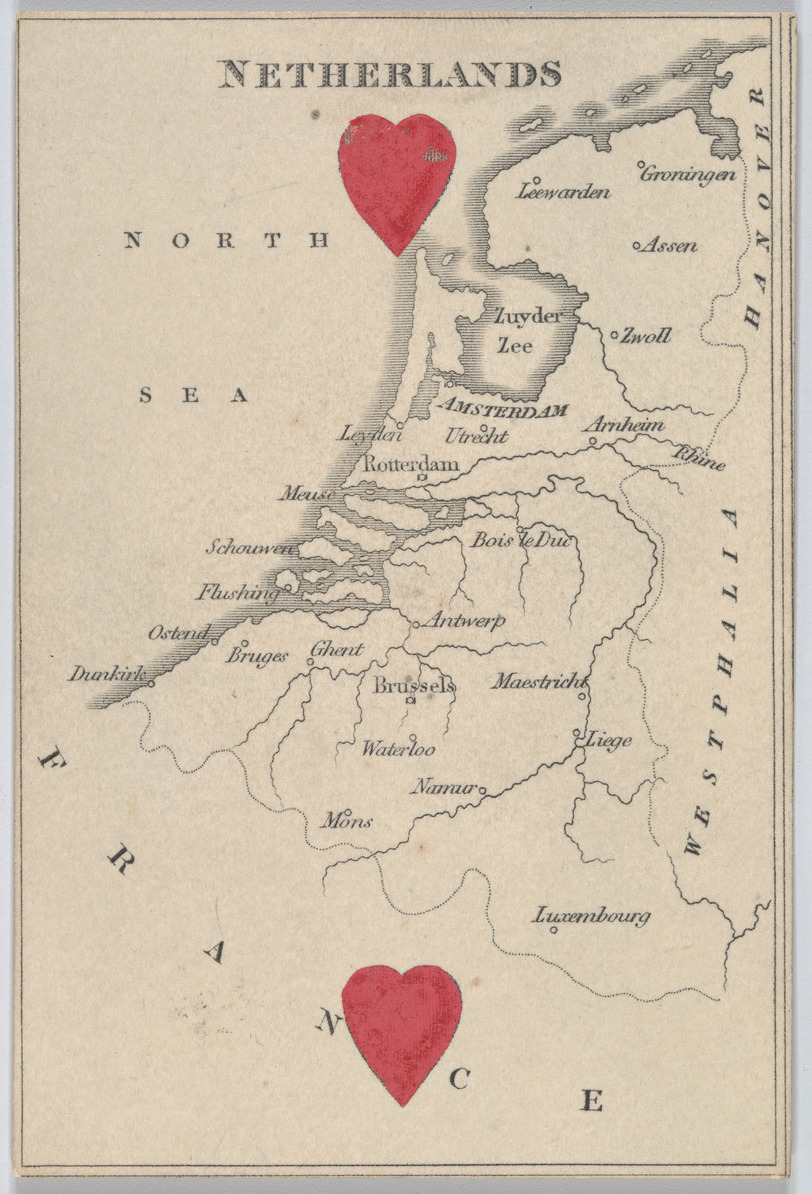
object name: print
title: Netherlands, from "Court Game of Geography"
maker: william and henry rock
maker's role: publisher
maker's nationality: british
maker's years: 1821-1884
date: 1838-1855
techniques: engraving, hand coloring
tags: playing cards,maps